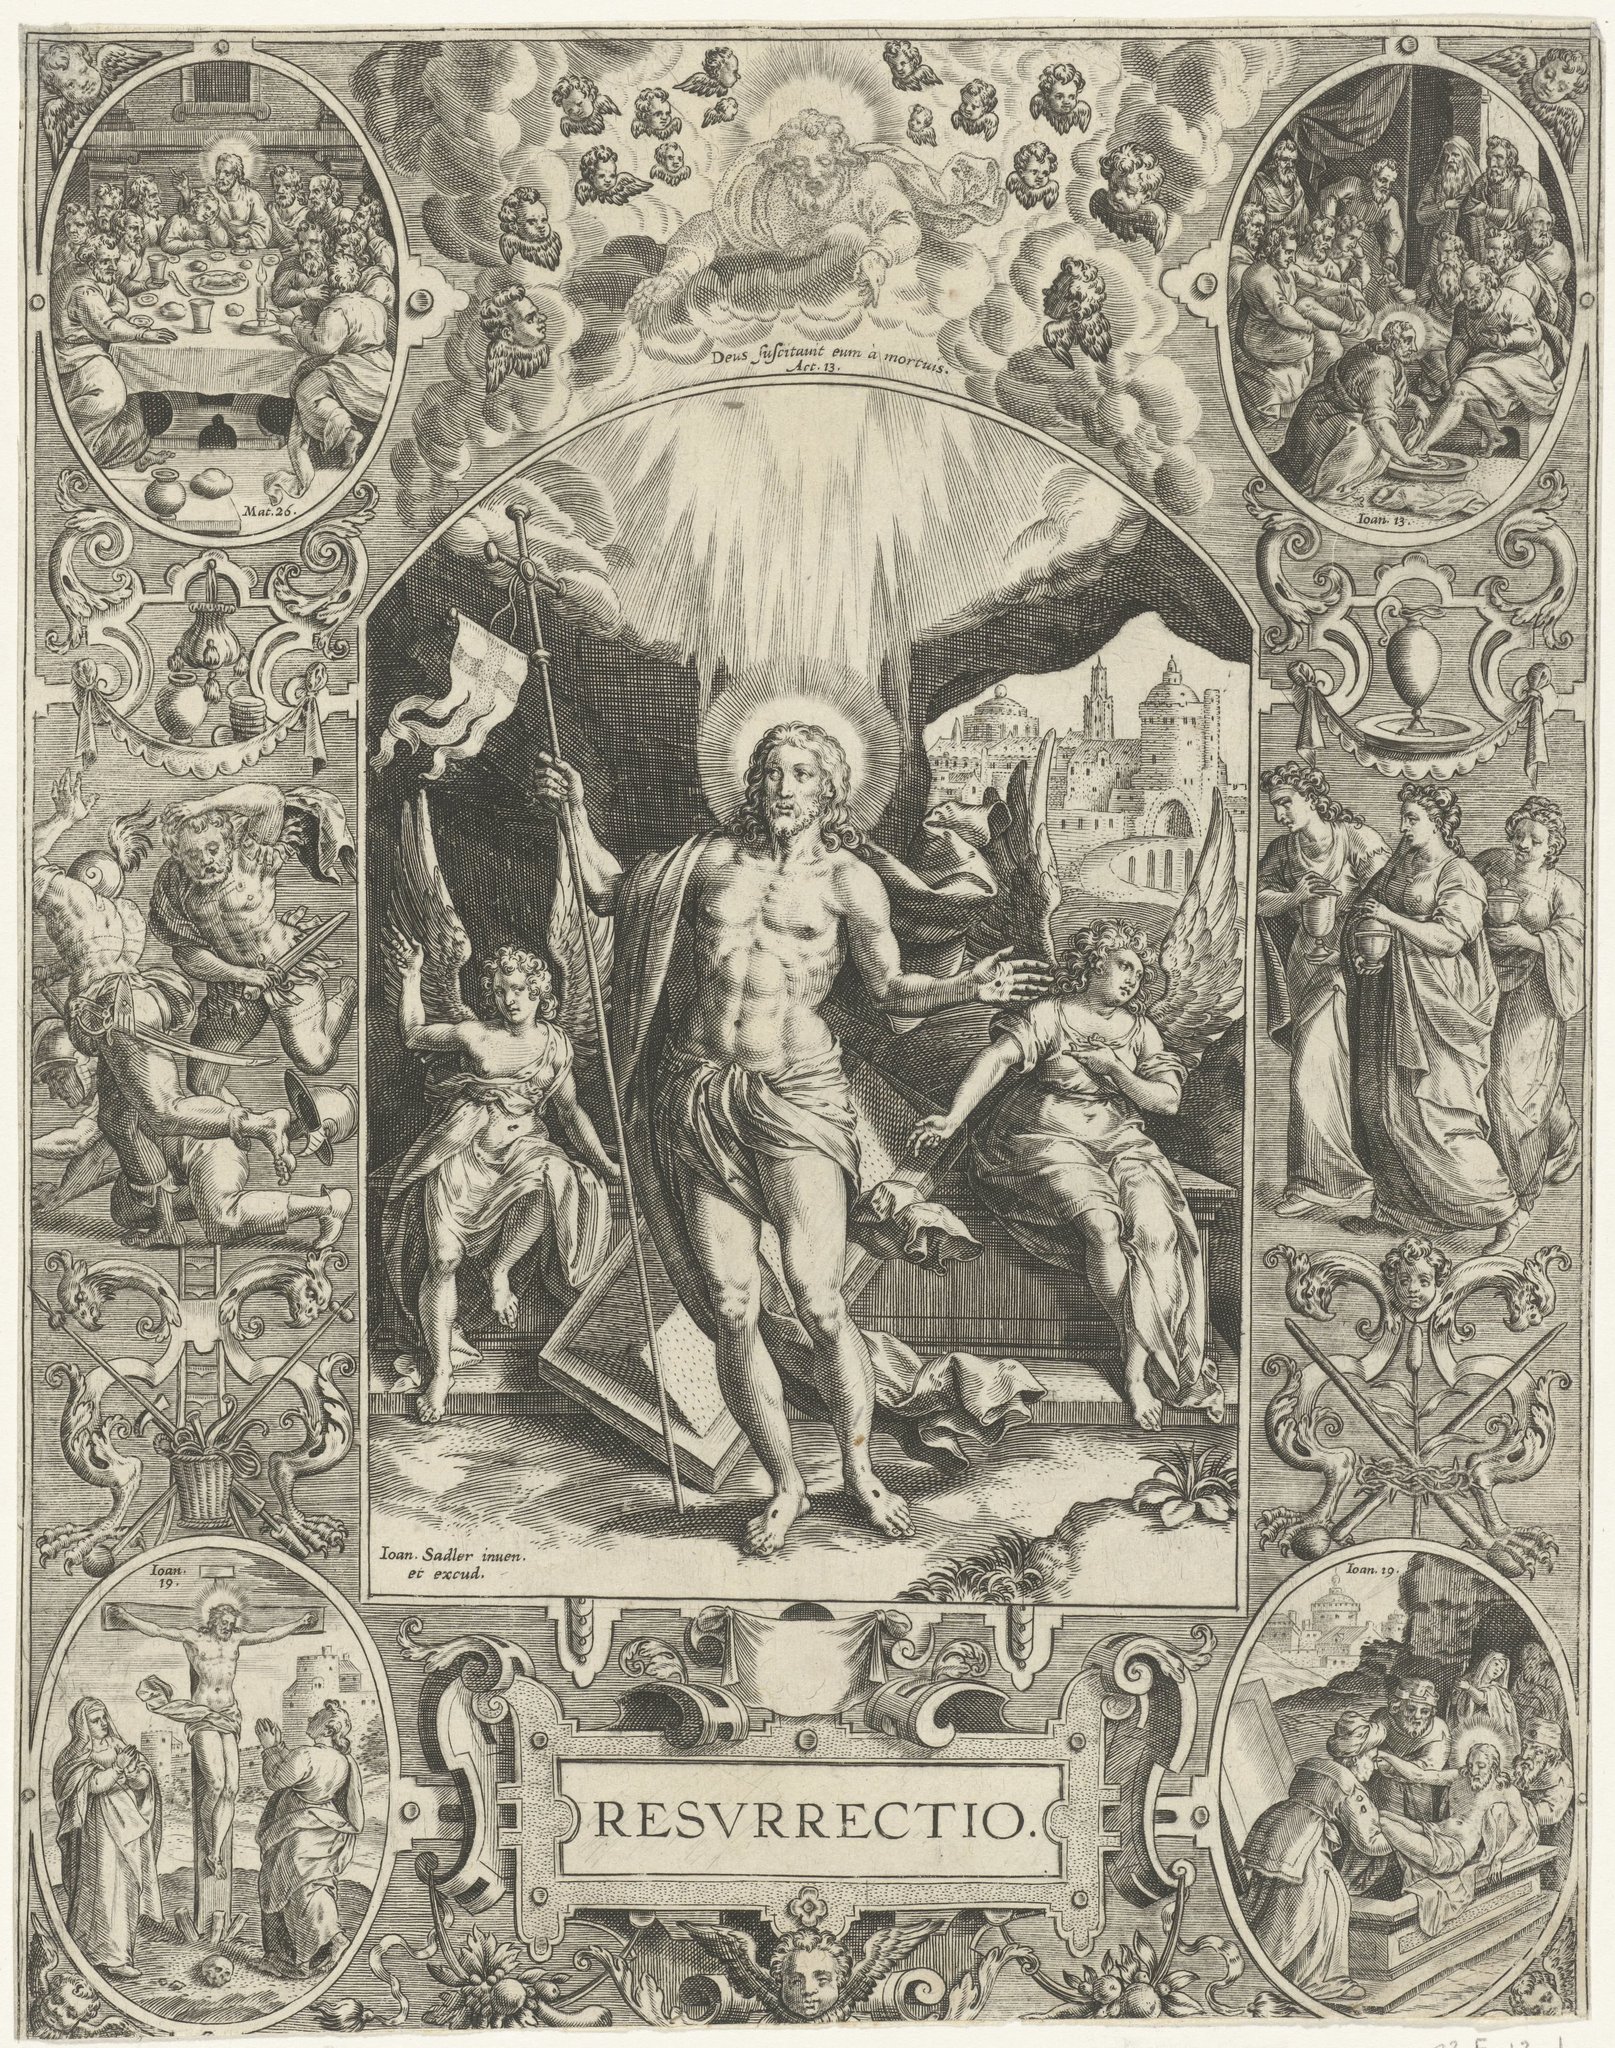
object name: print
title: De vier belangrijkste Christelijke feestdagen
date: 1560-1600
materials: paper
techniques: engraving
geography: antwerp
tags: easter, christ's entombment (possibly by angels), cherubs, i.e. children's heads with wings, the episode of the last supper, christ washes peter's feet, christ, usually holding a banner, arises from the grave; often combined with sleeping and/or frightened soldiers, god the father as bearded old man, usually with crown or tiara or sceptre and/or globe, crucified christ with mary and john on either side of the cross; holy rood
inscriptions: collector's mark: Lugt 2228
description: Christus verrijst uit zijn graf. Aan weerszijden van zijn graf een engel. In ornamentlijst links vluchtende soldaten en rechts de drie vrouwen die naar het graf gaan. In de vier hoeken scènes uit de passie van Christus in ovalen. Middenboven engelenkoren met God de Vader.